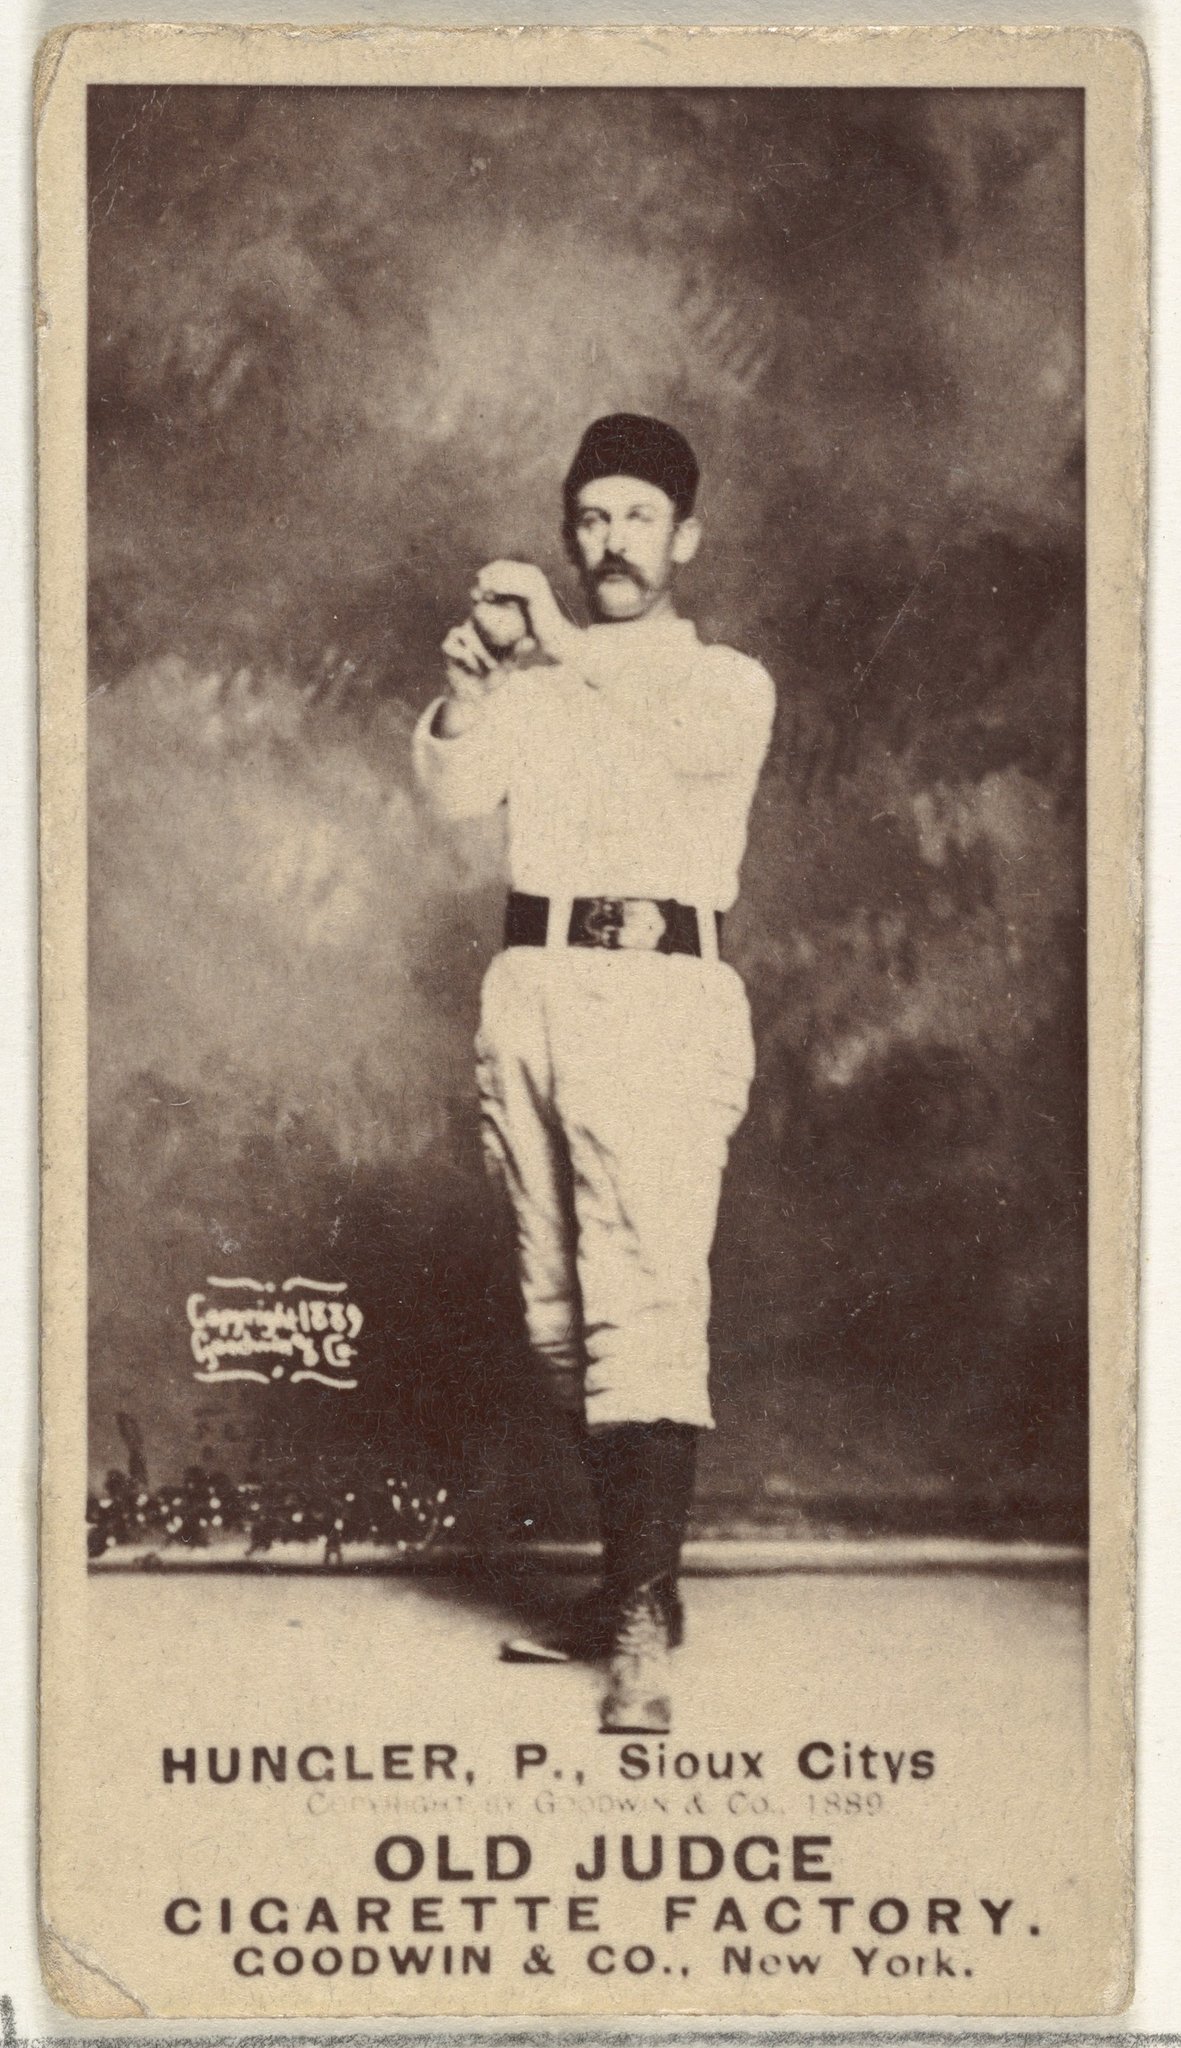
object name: baseball card, photograph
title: Al C. Hungler, Pitcher, Sioux City Corn Huskers, from the Old Judge series (N172) for Old Judge Cigarettes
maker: goodwin & company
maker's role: publisher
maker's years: 1850-1950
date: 1889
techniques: albumen silver print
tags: men,portraits,baseball,athletes